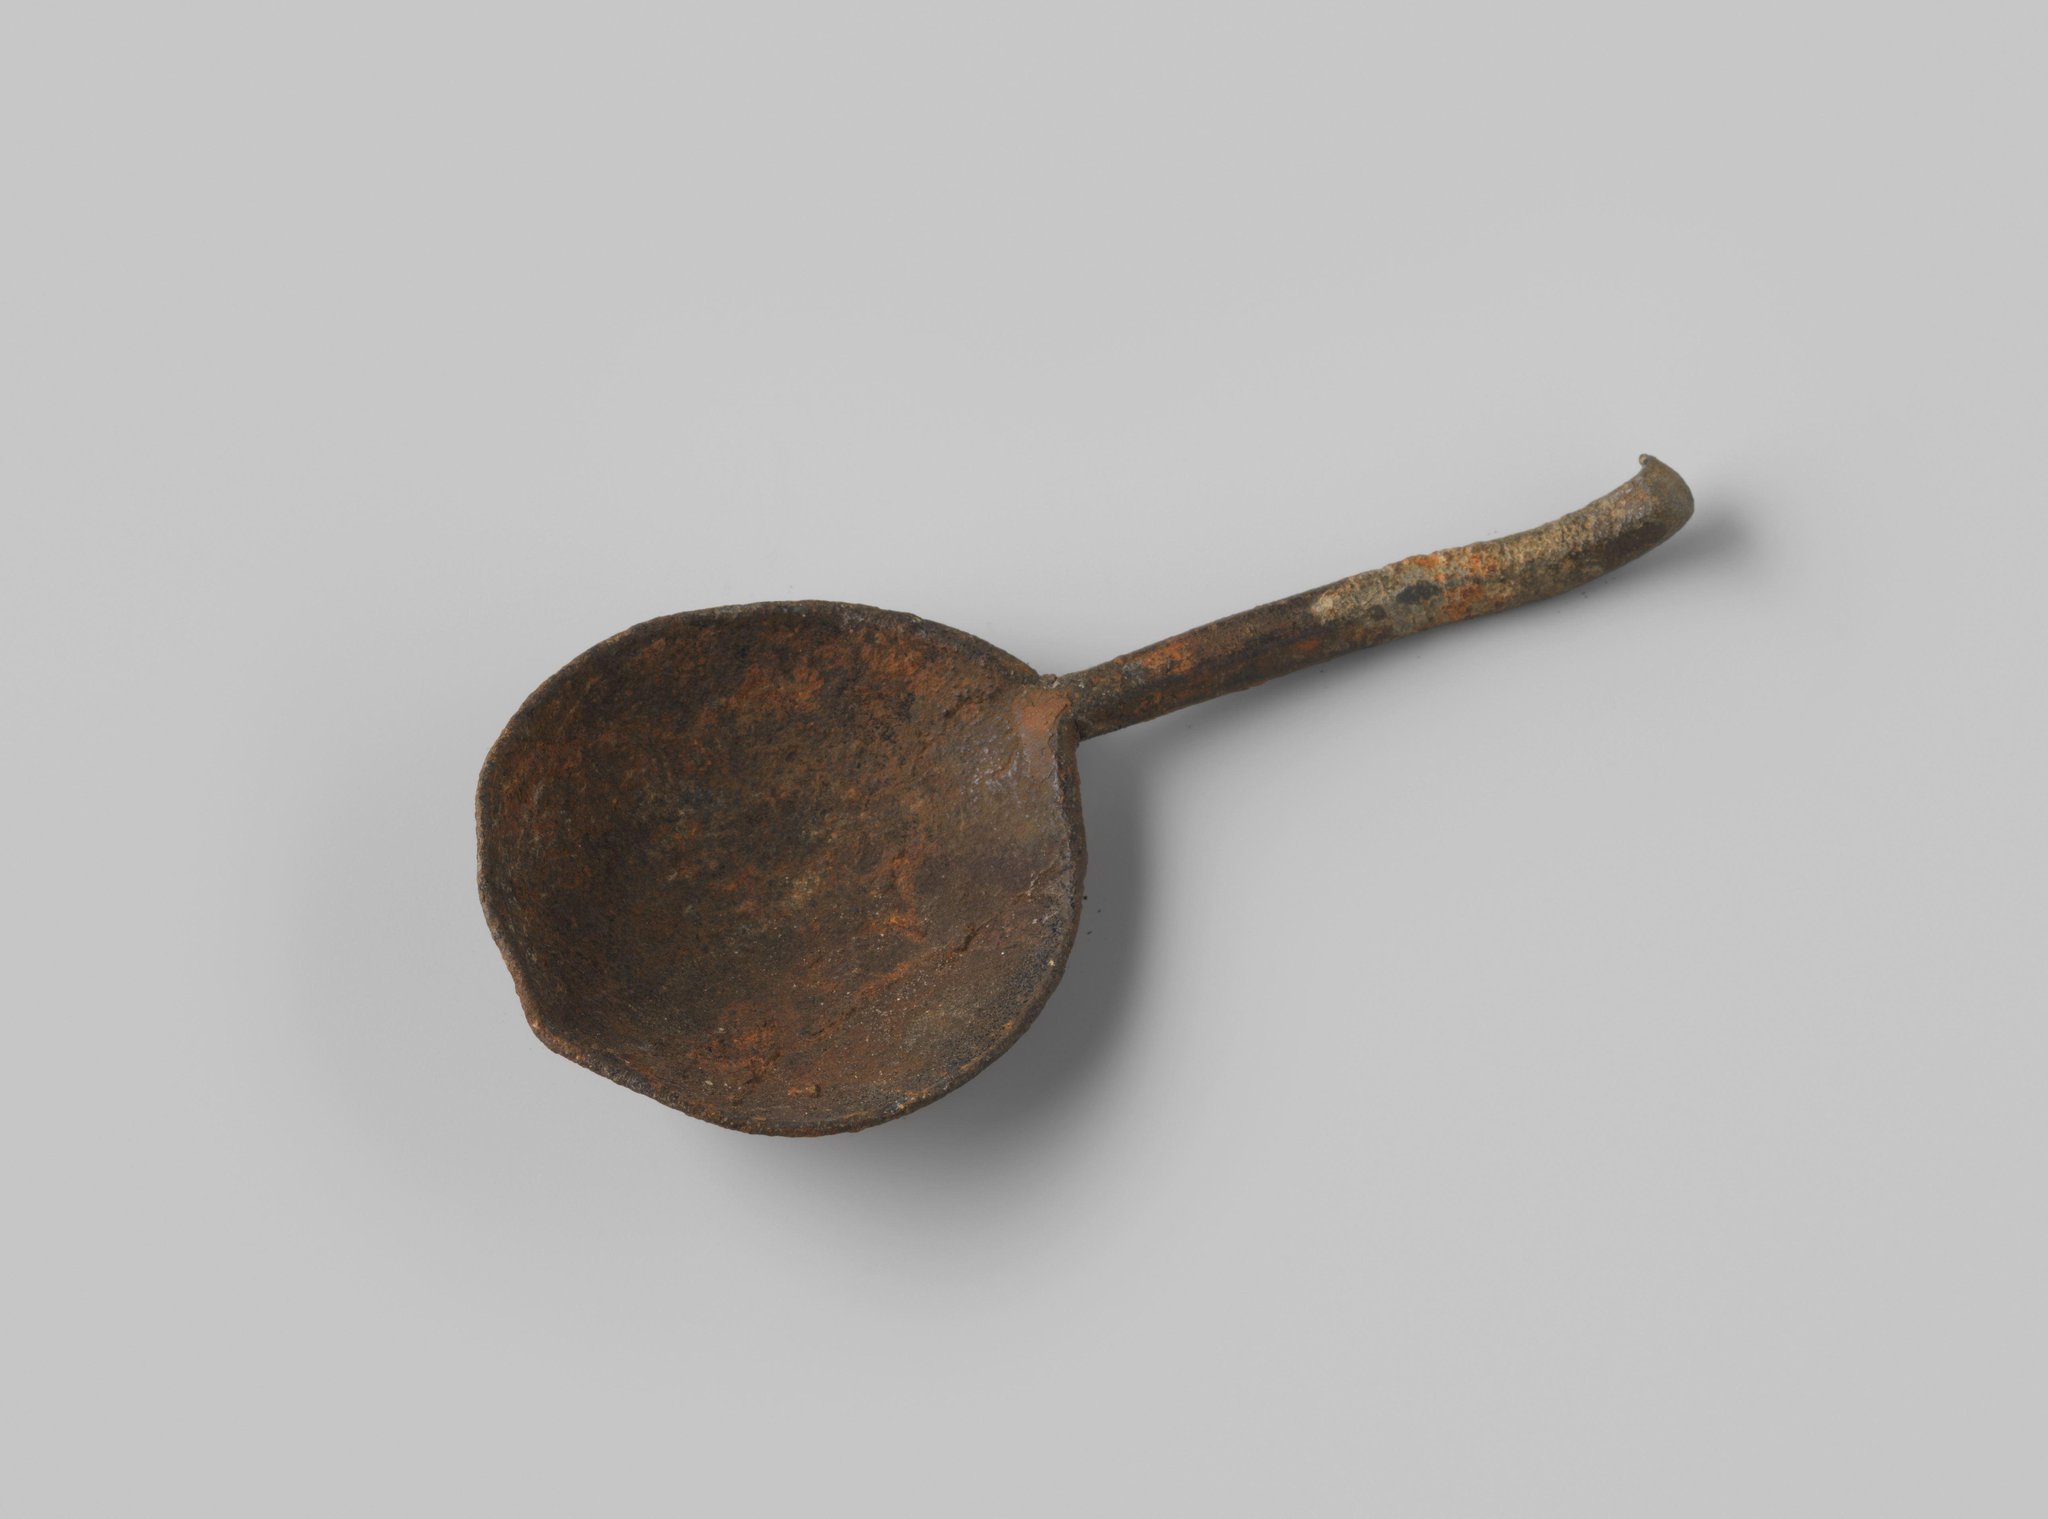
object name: spoon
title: Lepel uit het wrak van de Oost-Indiëvaarder Meresteijn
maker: Anonymous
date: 1693-1702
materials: tin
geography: netherlands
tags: cape of good hope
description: Tinnen lepel: massieve ronde steel (deel) met ronde komvormige lepel, gecorrodeerd.